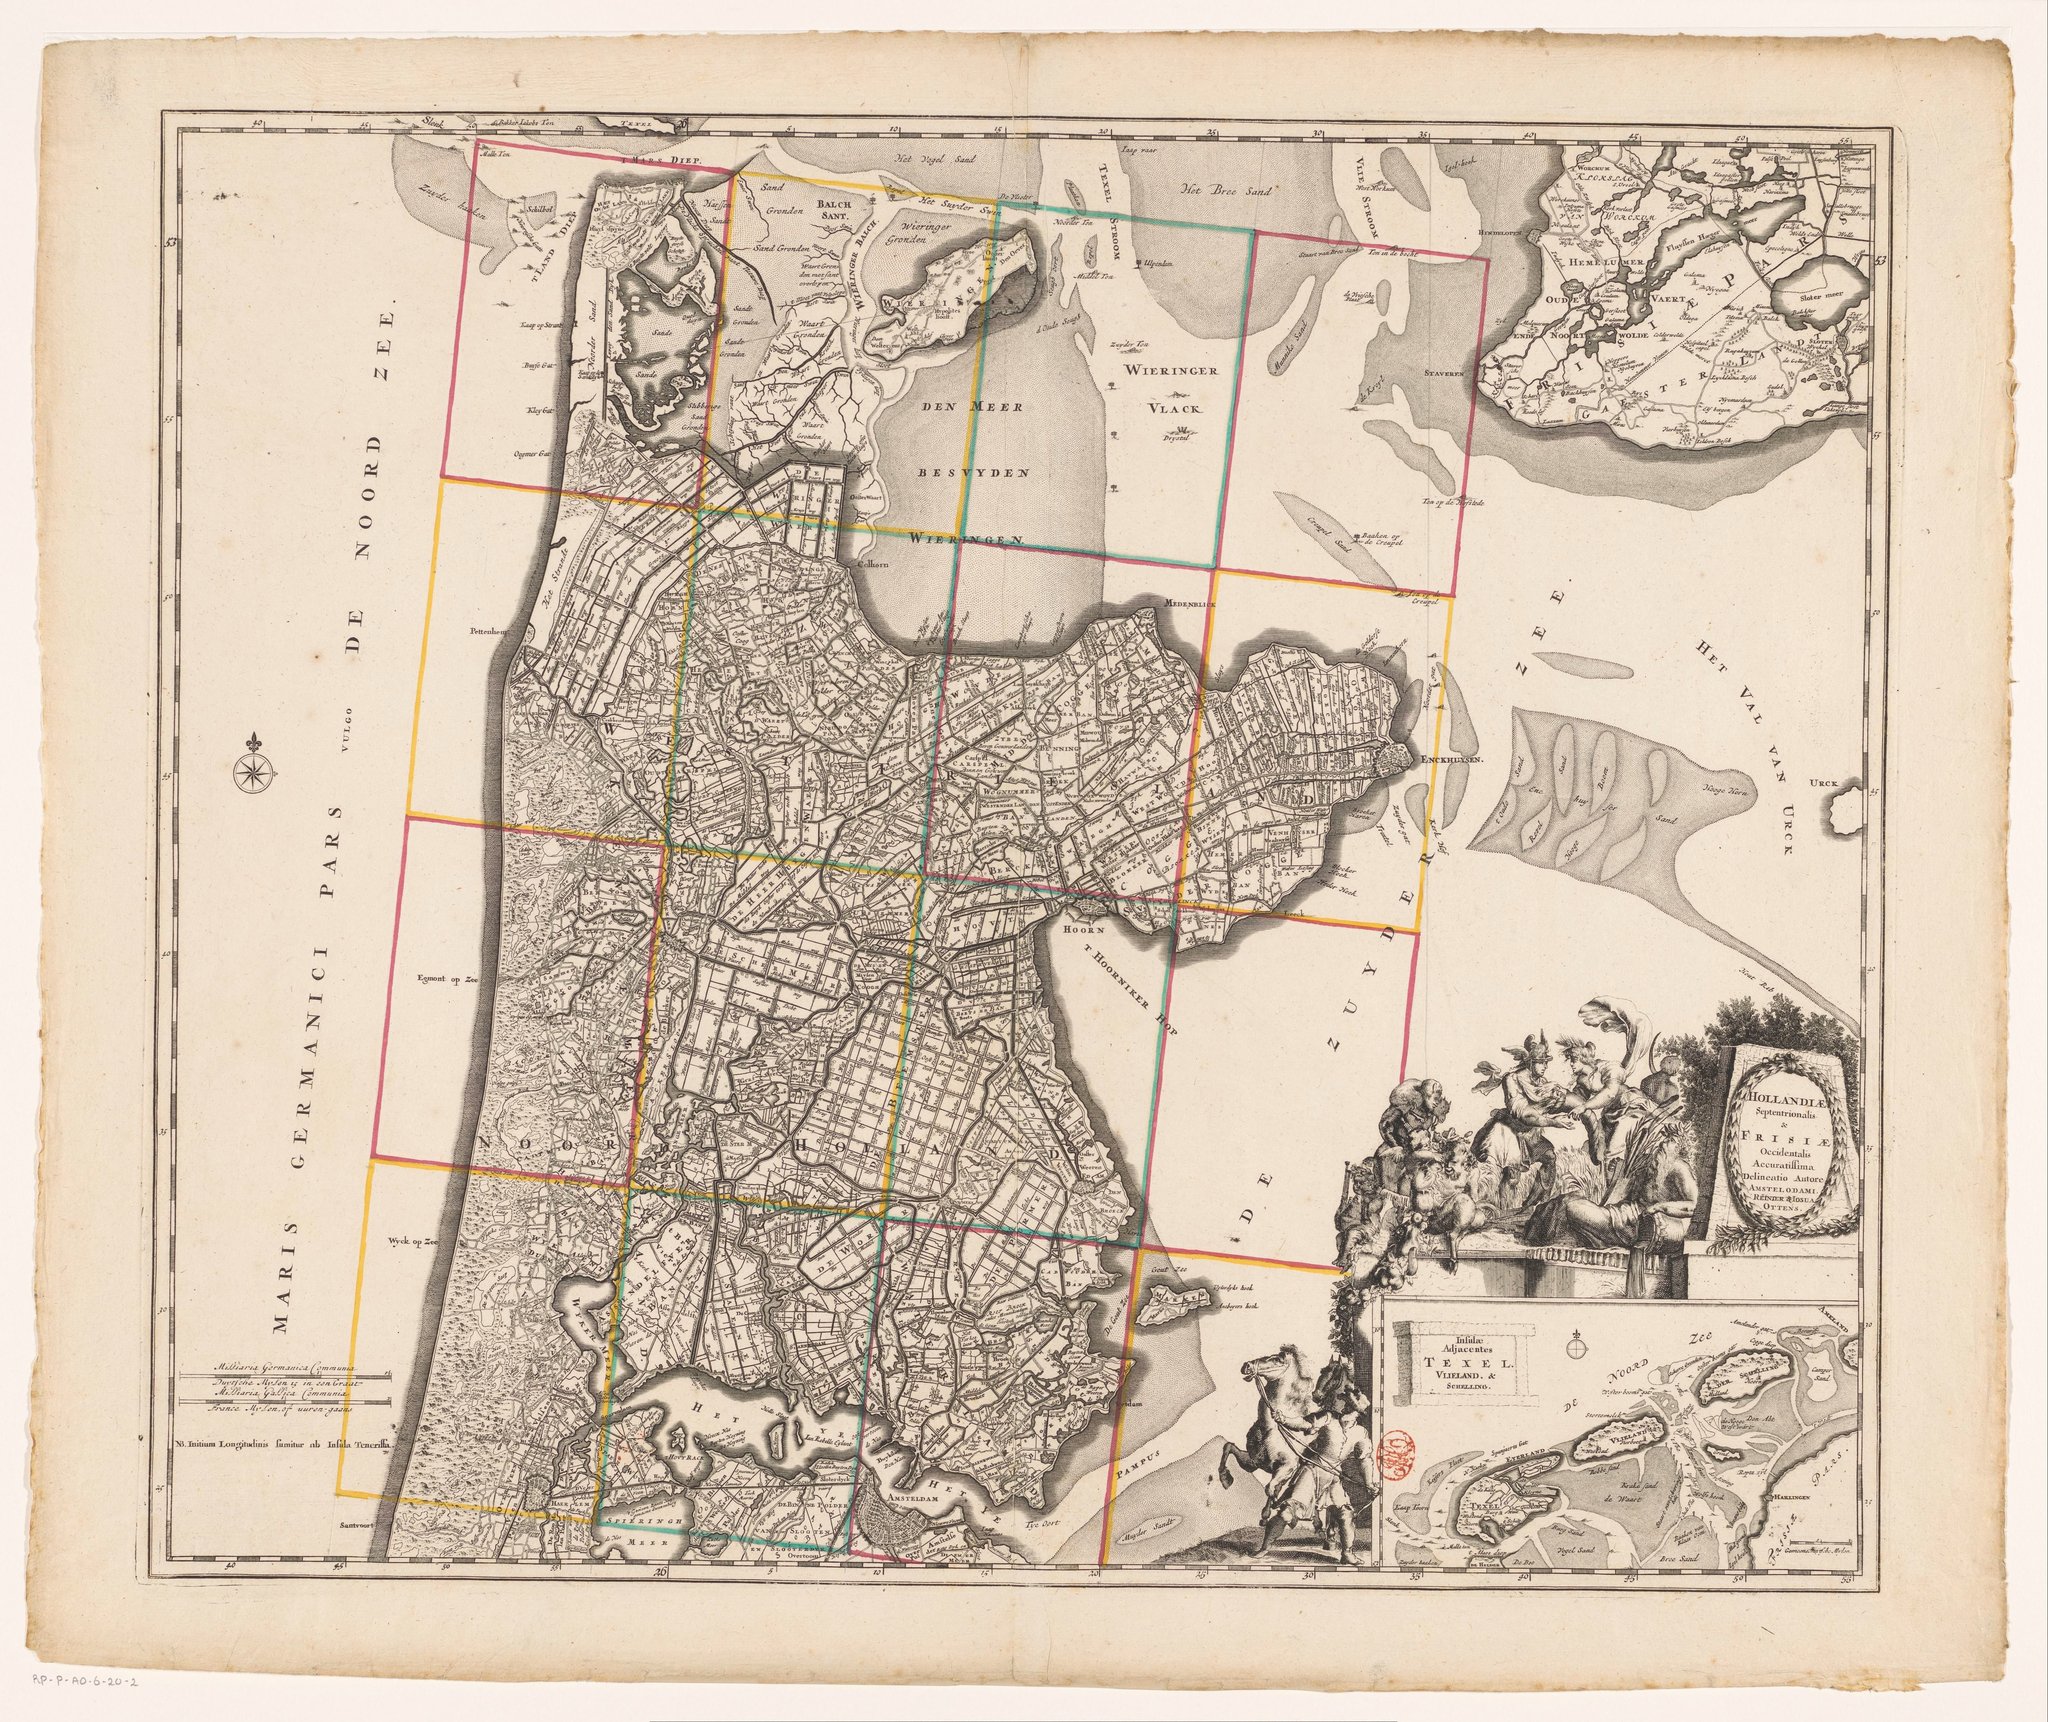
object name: map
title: Hollandiae septentrionalis & Frisiae occidentalis accuratissima delineatio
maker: Anonymous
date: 1726-1750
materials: paper, pencil, watercolor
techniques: brush, engraving, etching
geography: amsterdam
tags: 'cornucopia', horn of plenty, maps of separate countries or regions, (story of) mercury (hermes), river-gods, satyr(s) (in general)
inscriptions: collector's mark: Lugt 195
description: Linksonder twee schaalstokken: Milliaria Germanica communia / Duytsche mylen 15 in een graat; Milliaria Gallica communia / France mylen, of uuren gaans. Rechtsonder de titelcartouche met daaromheen verschillende figuren waaronder een man met een paard, saters, putti, Mercurius die de hoorn des overvloeds aanneemt van een vrouwfiguur, en een riviergod. Daaronder een inzetkaart van het Waddengebied met een schaalstok: Gemeene Duytsche mylen. Gradenverdeling langs de randen. Met gekleurd rooster.